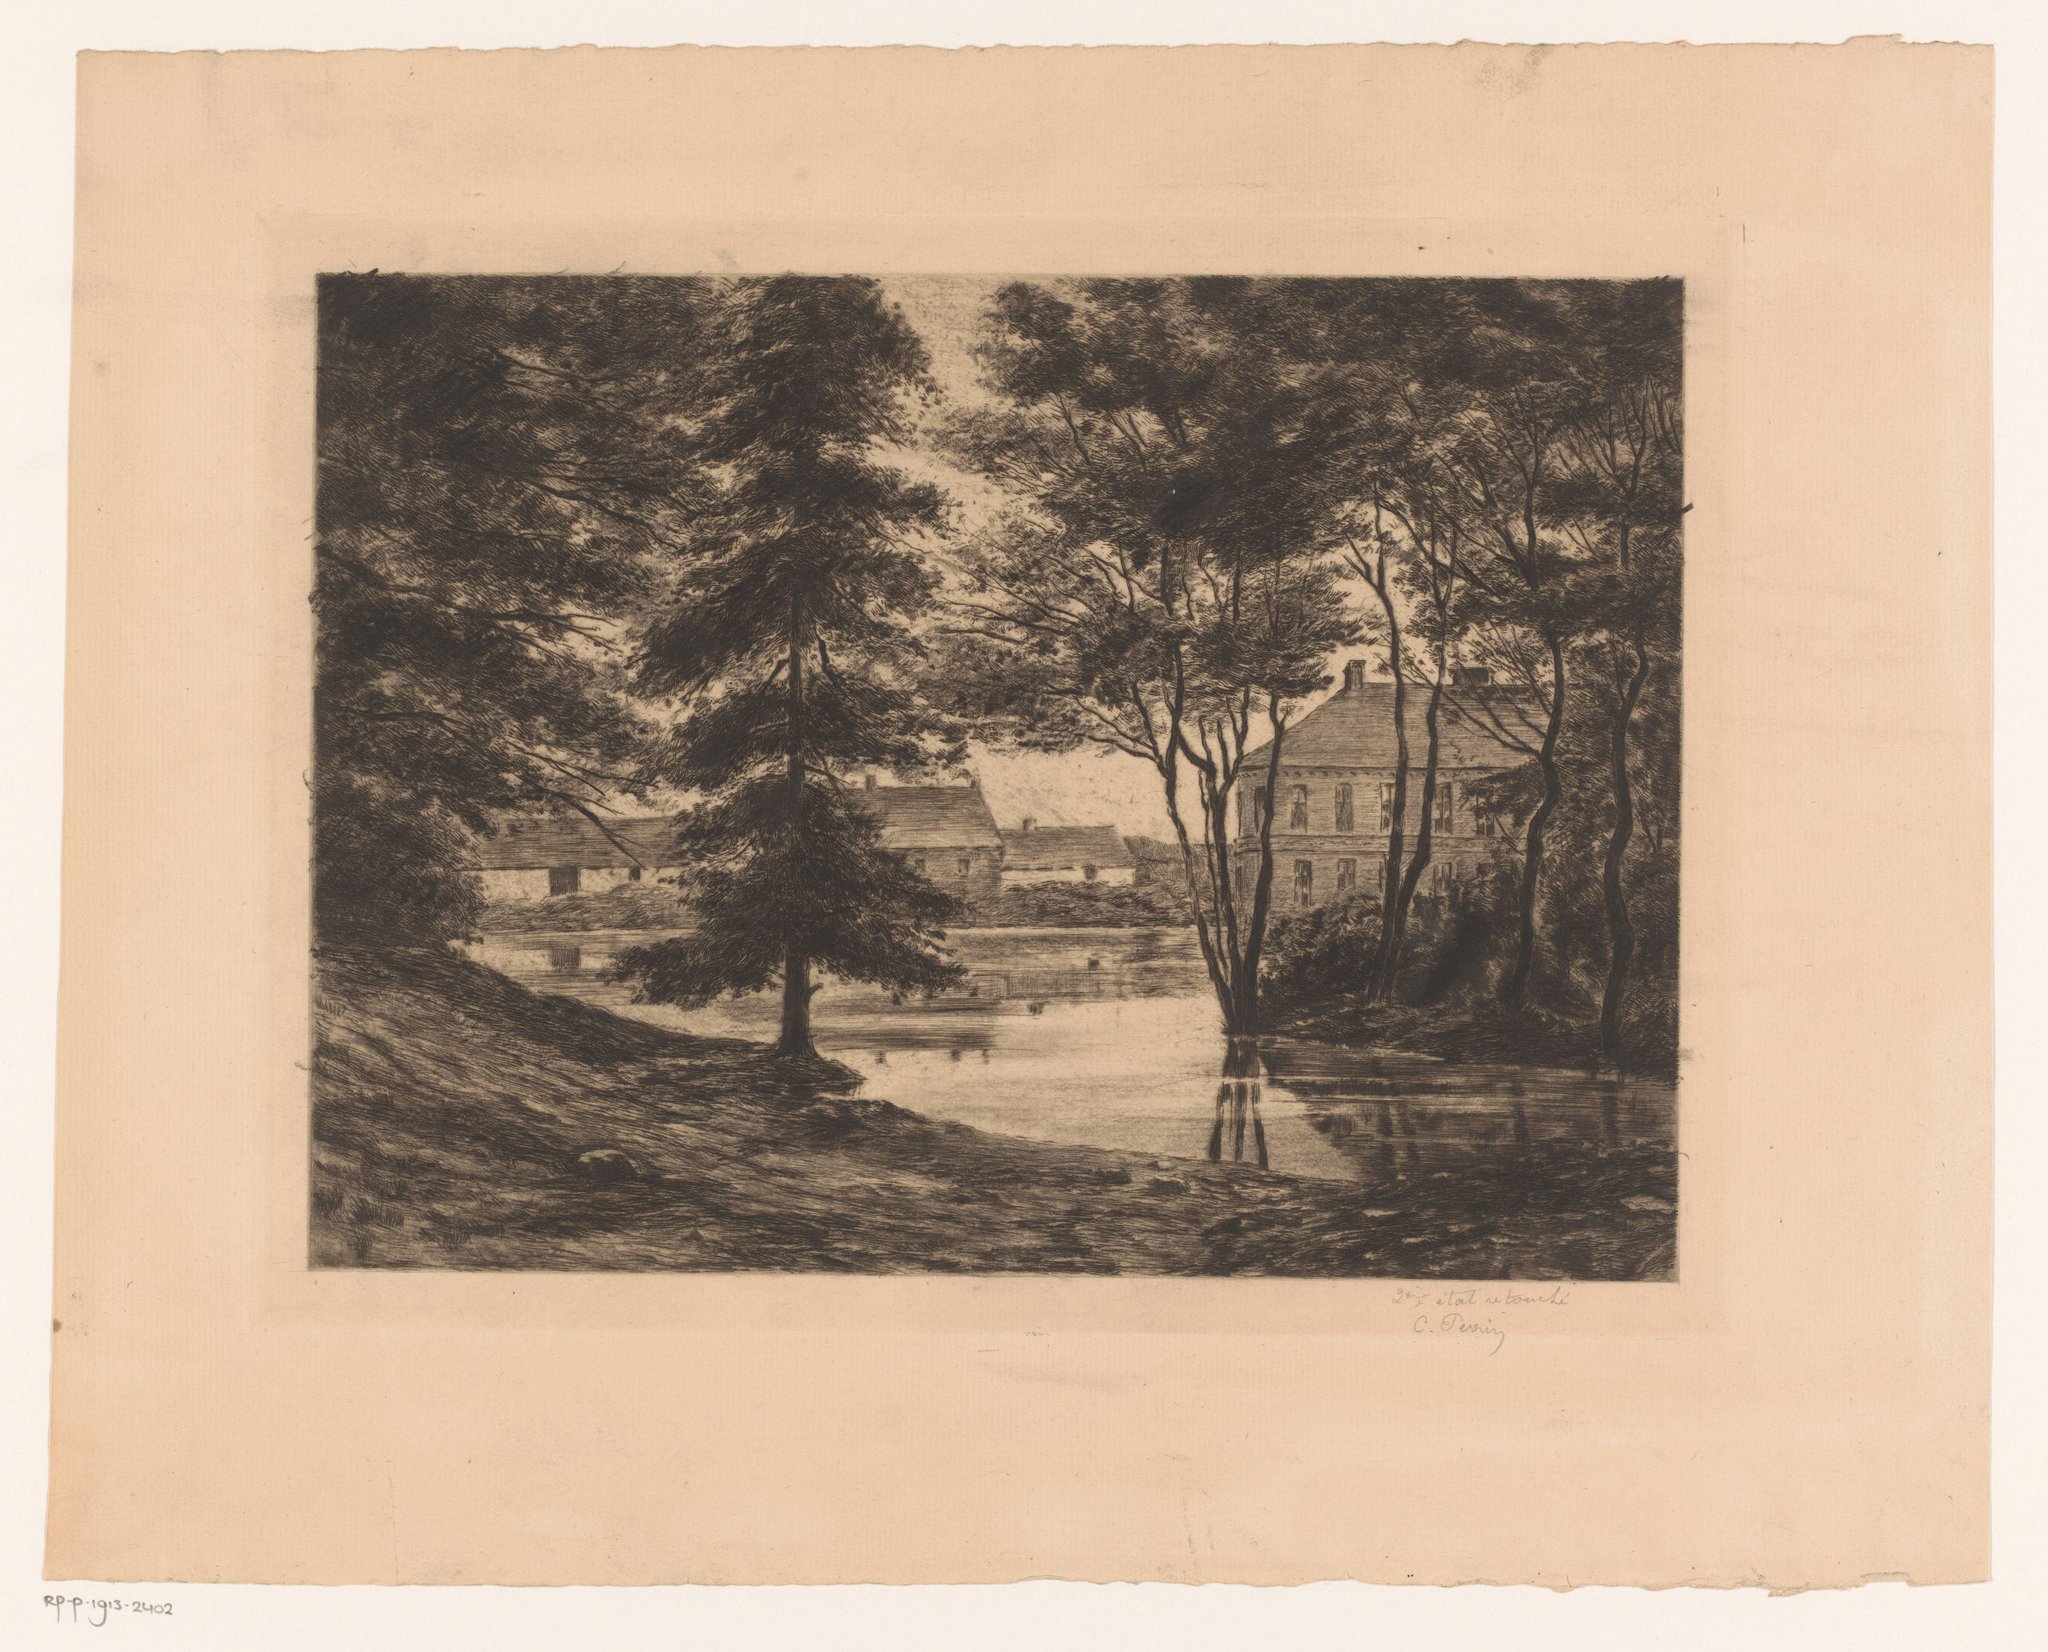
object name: print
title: Gezicht op kasteel Ghlin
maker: ch. perrin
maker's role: print maker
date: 1850-1913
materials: paper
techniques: drypoint, etching, intaglio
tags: castle, forest, wood, landscape with tower or castle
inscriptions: annotation: ‘2ème état retouché’, collector's mark: Lugt 2228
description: Geboorte- en sterfdatum van de prentmaker zijn onbekend. Daarom is voor de bepaling van de rechten van dit object gebruik gemaakt van de verwervingsdatum Rijksmuseum Amsterdam.